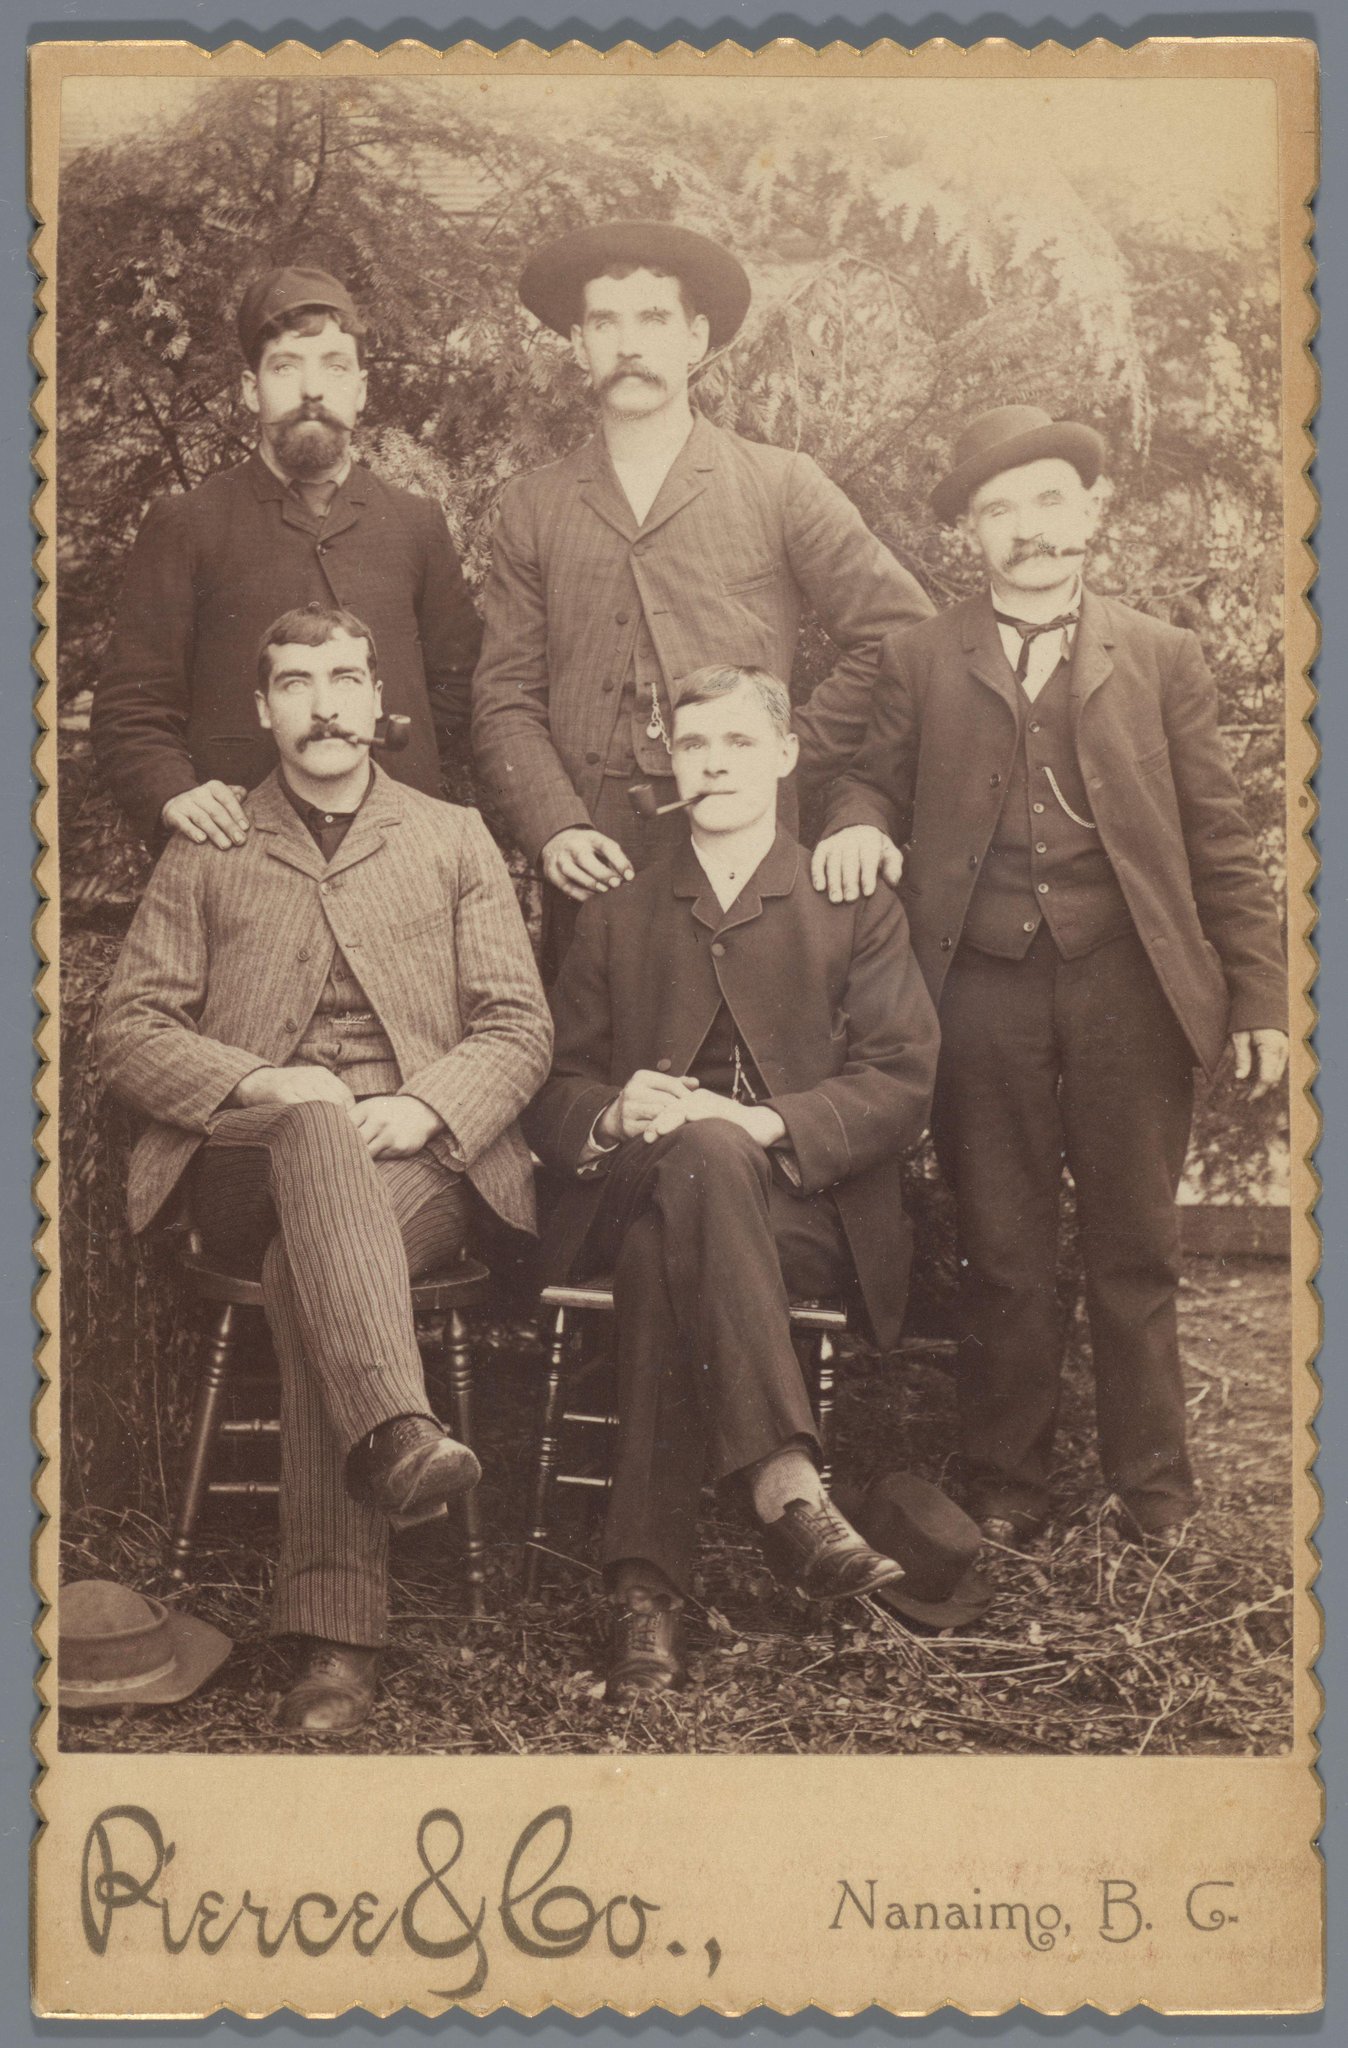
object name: cabinet photograph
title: Nanaimo, B.C. , Portret van 5 mannen, waaronder John Macquarrie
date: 1885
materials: photographic support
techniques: albumen print